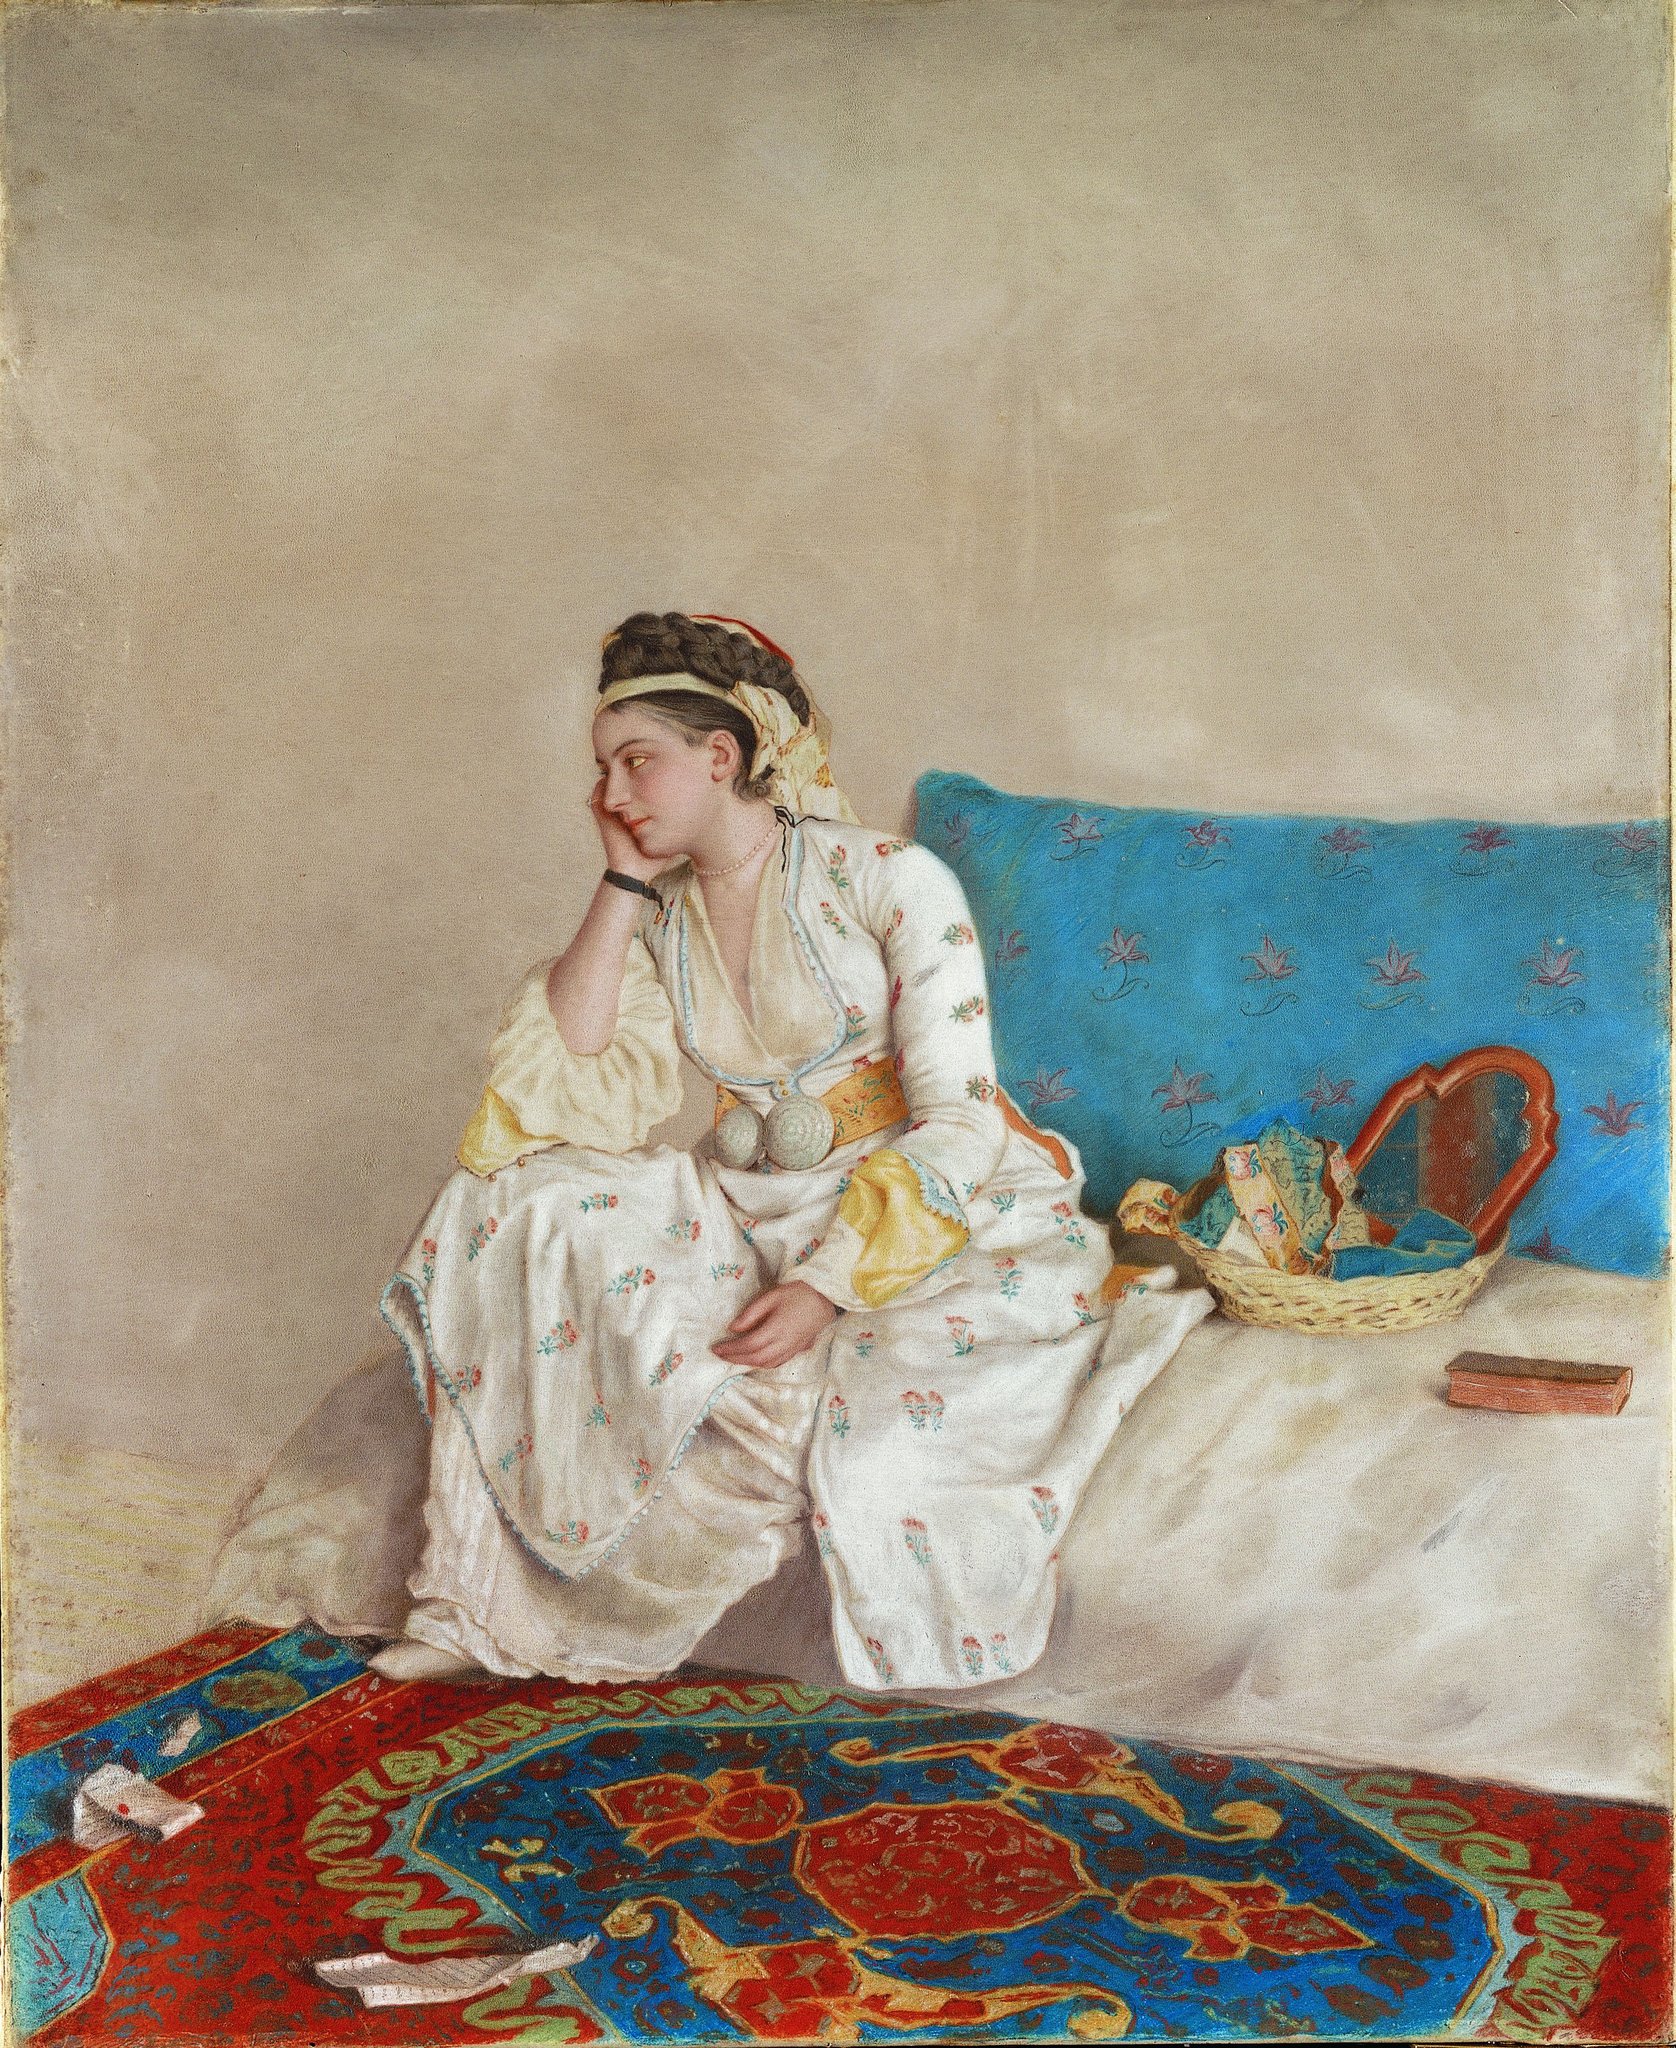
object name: drawing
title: Woman in Turkish Dress, Seated on a Sofa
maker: jean etienne liotard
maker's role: artist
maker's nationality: swiss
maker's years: 1702-1789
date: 1751-1752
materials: chalk, parchment, pastel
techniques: drawing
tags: books,women,baskets